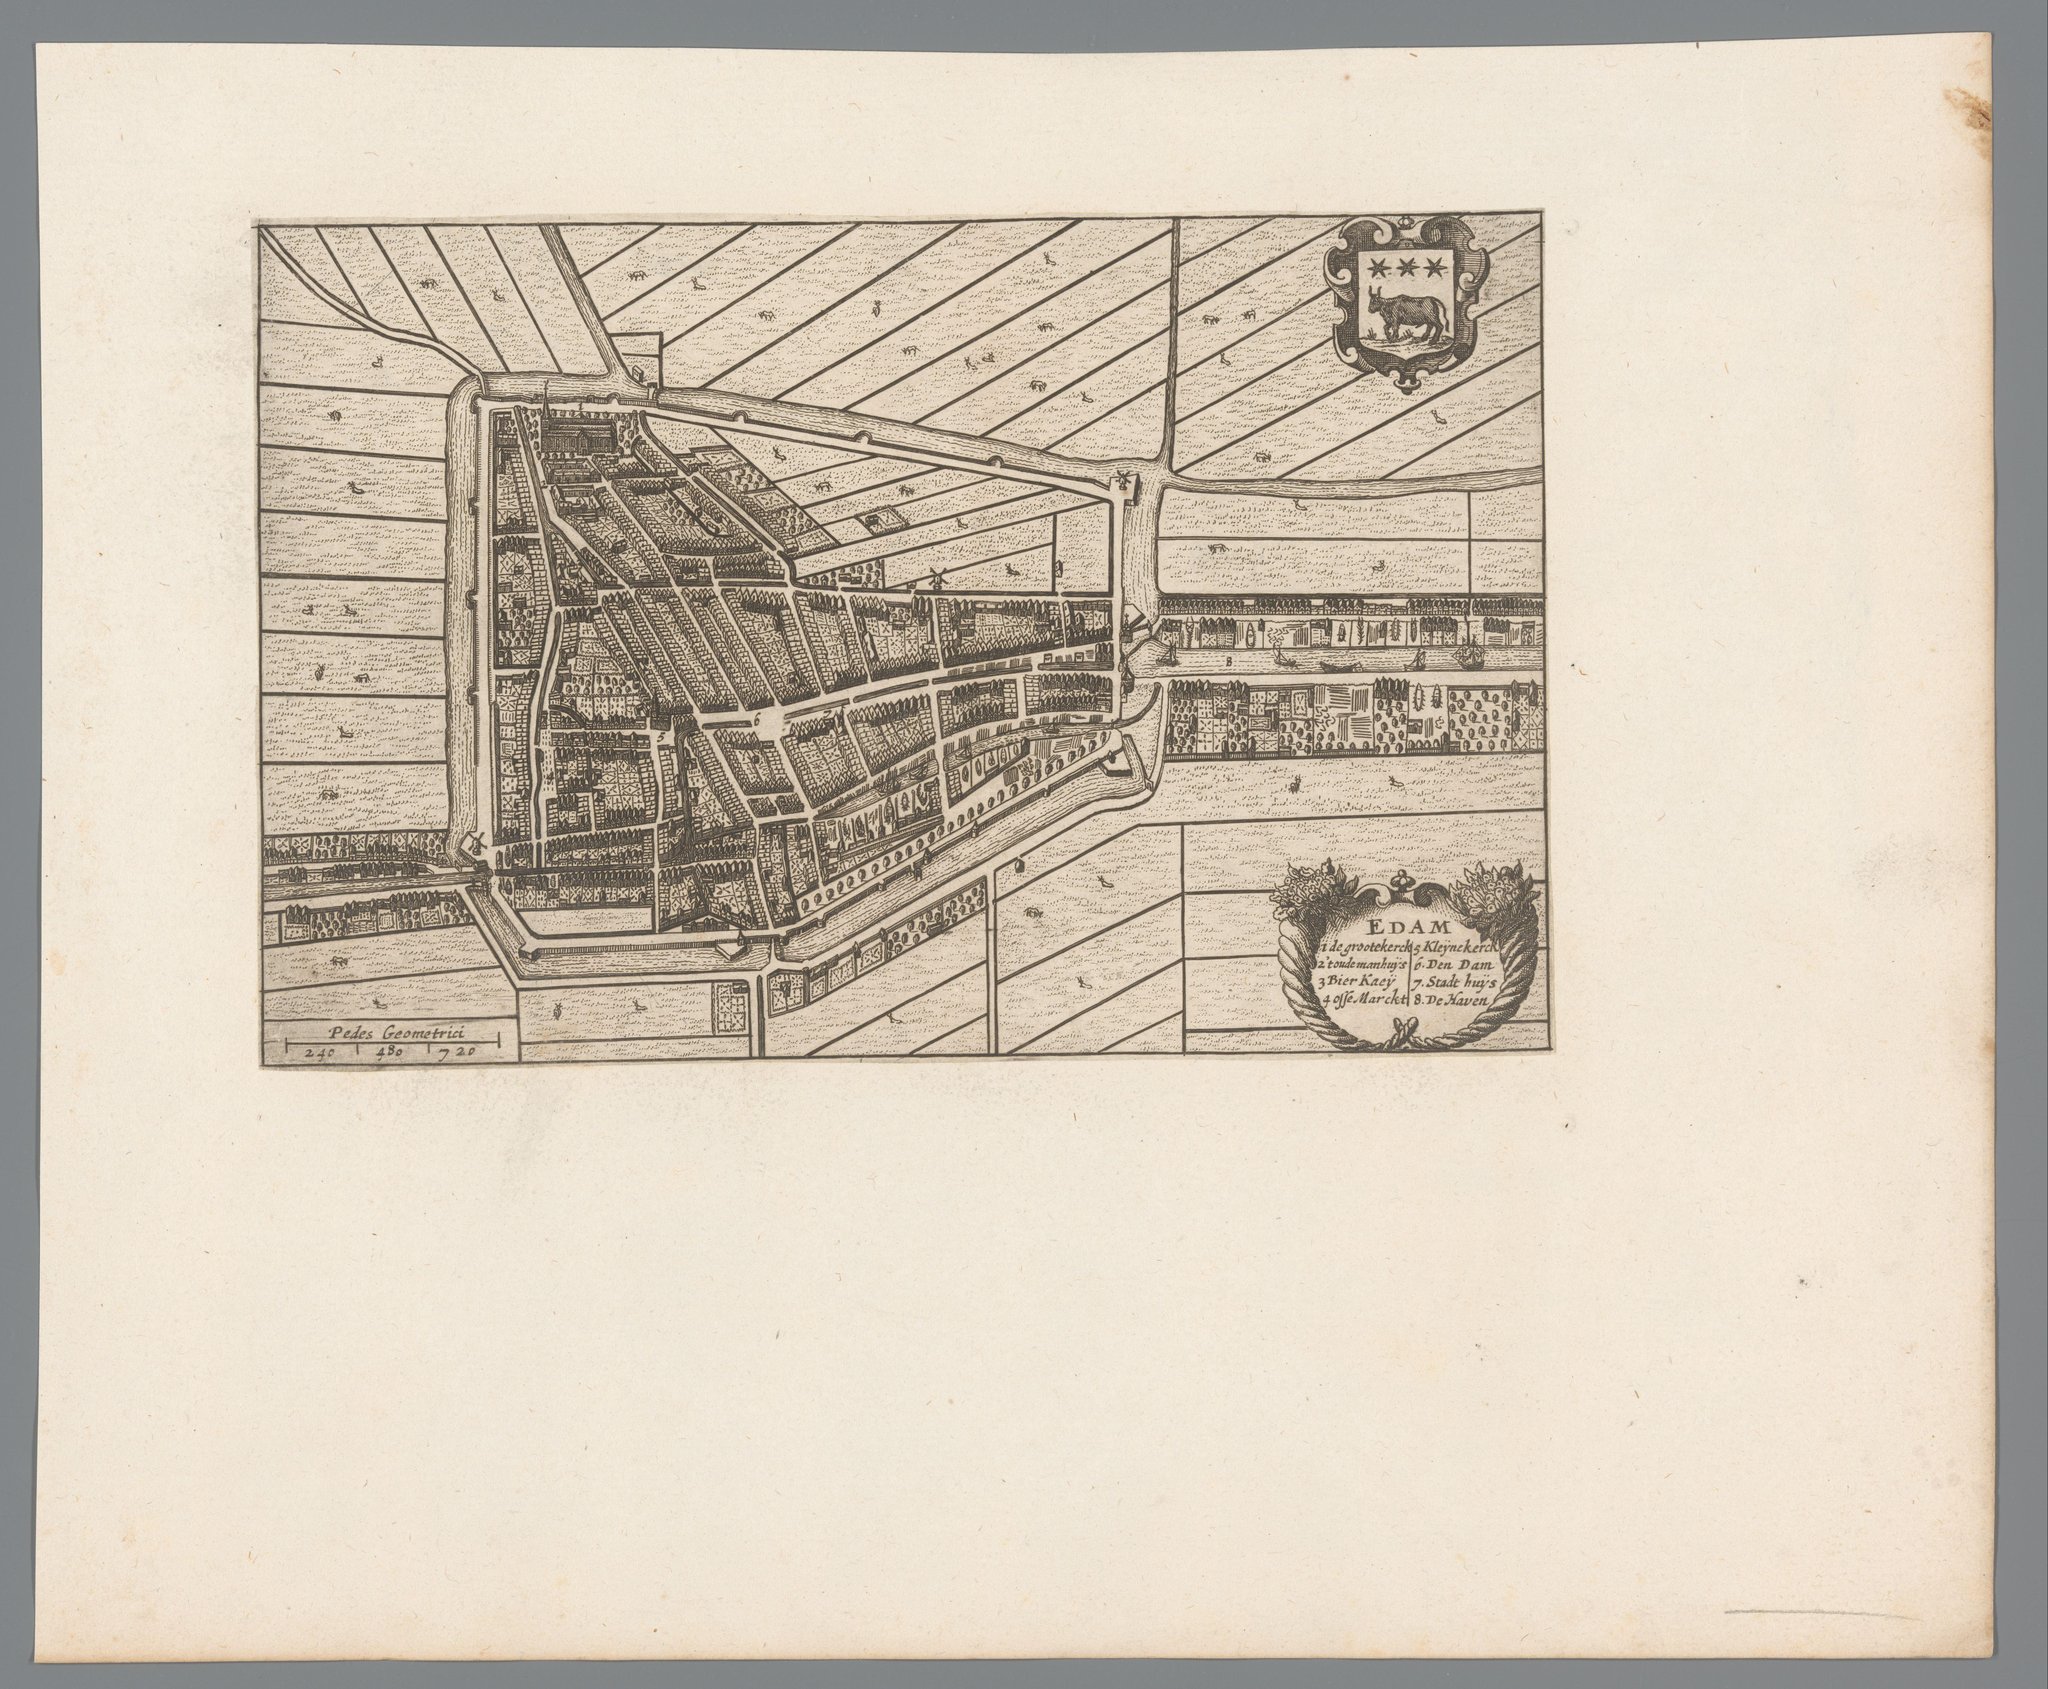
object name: area plan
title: Plattegrond van Edam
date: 1632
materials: paper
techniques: etching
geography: amsterdam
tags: maps of cities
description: Prent uit: Boxhorn, Marcus Zuerius. Theatrum sive Hollandiae comitatus et urbium nova descriptio (...). Amsterdam: Henricus Hondius, 1632.